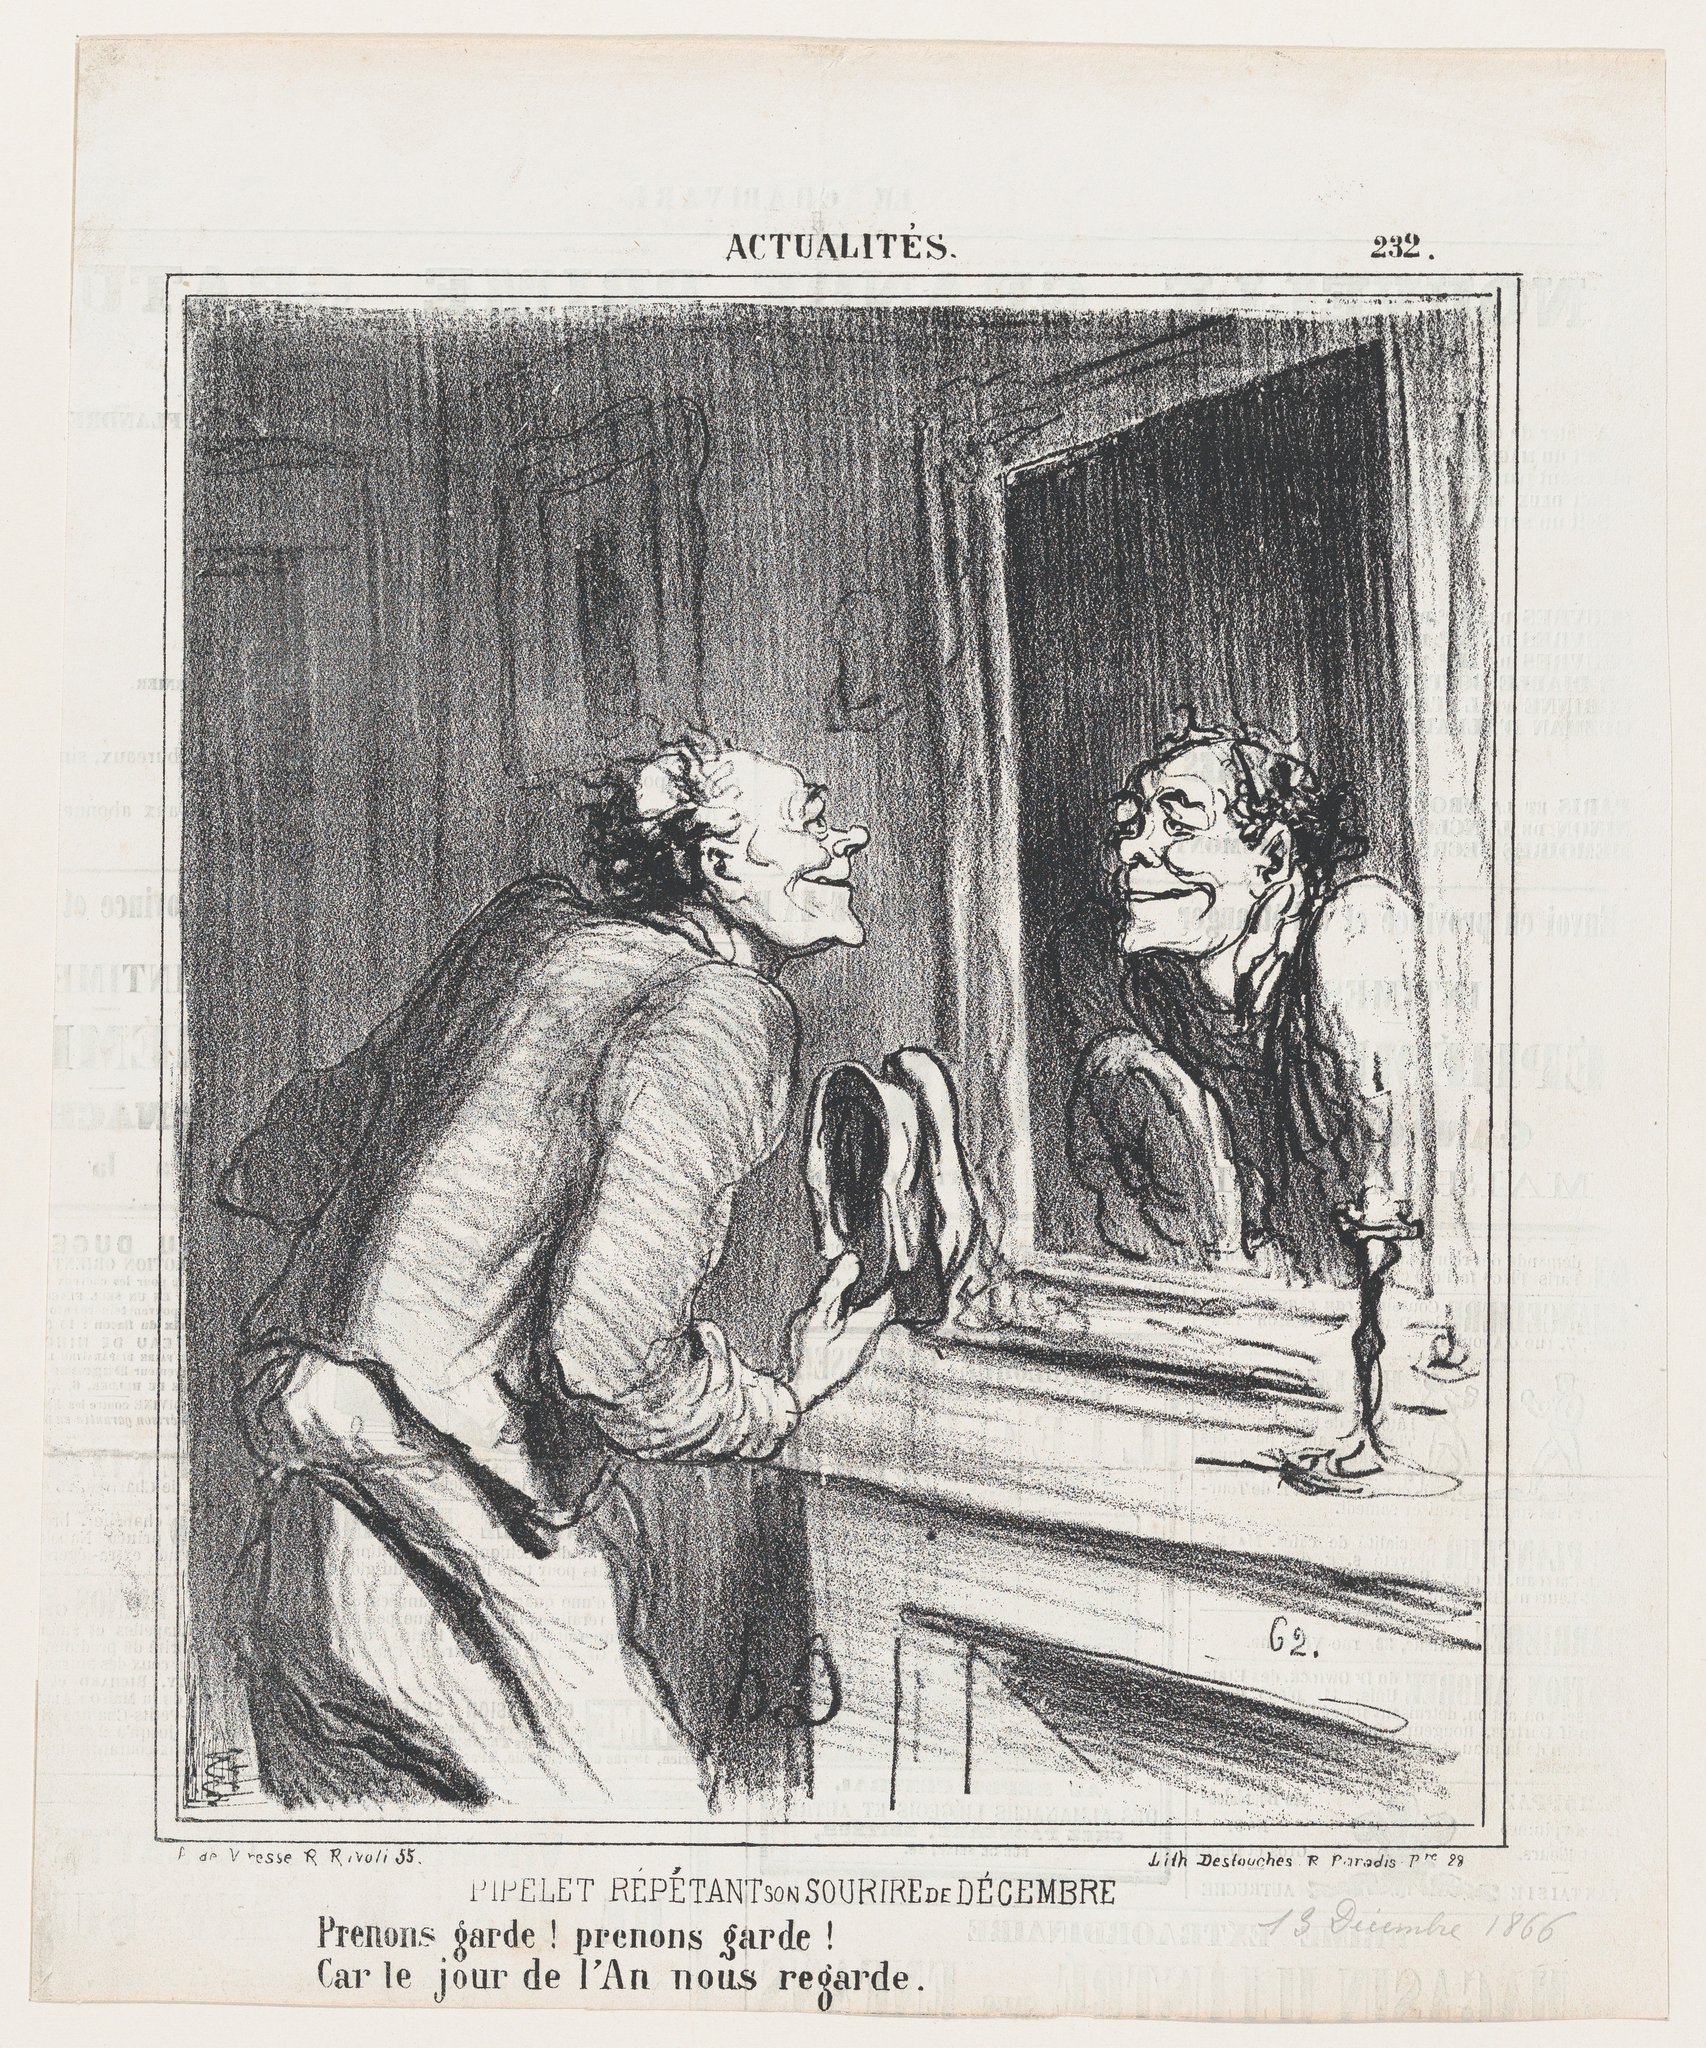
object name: print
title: The concierge rehearsing his December smile: Take care! take care! For New Year's Day is approaching!, from 'News of the day,' published in Le Charivari, December 13, 1866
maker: honoré daumier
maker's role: artist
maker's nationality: french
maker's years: 1808-1879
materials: paper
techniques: lithograph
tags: satire,men,mirrors